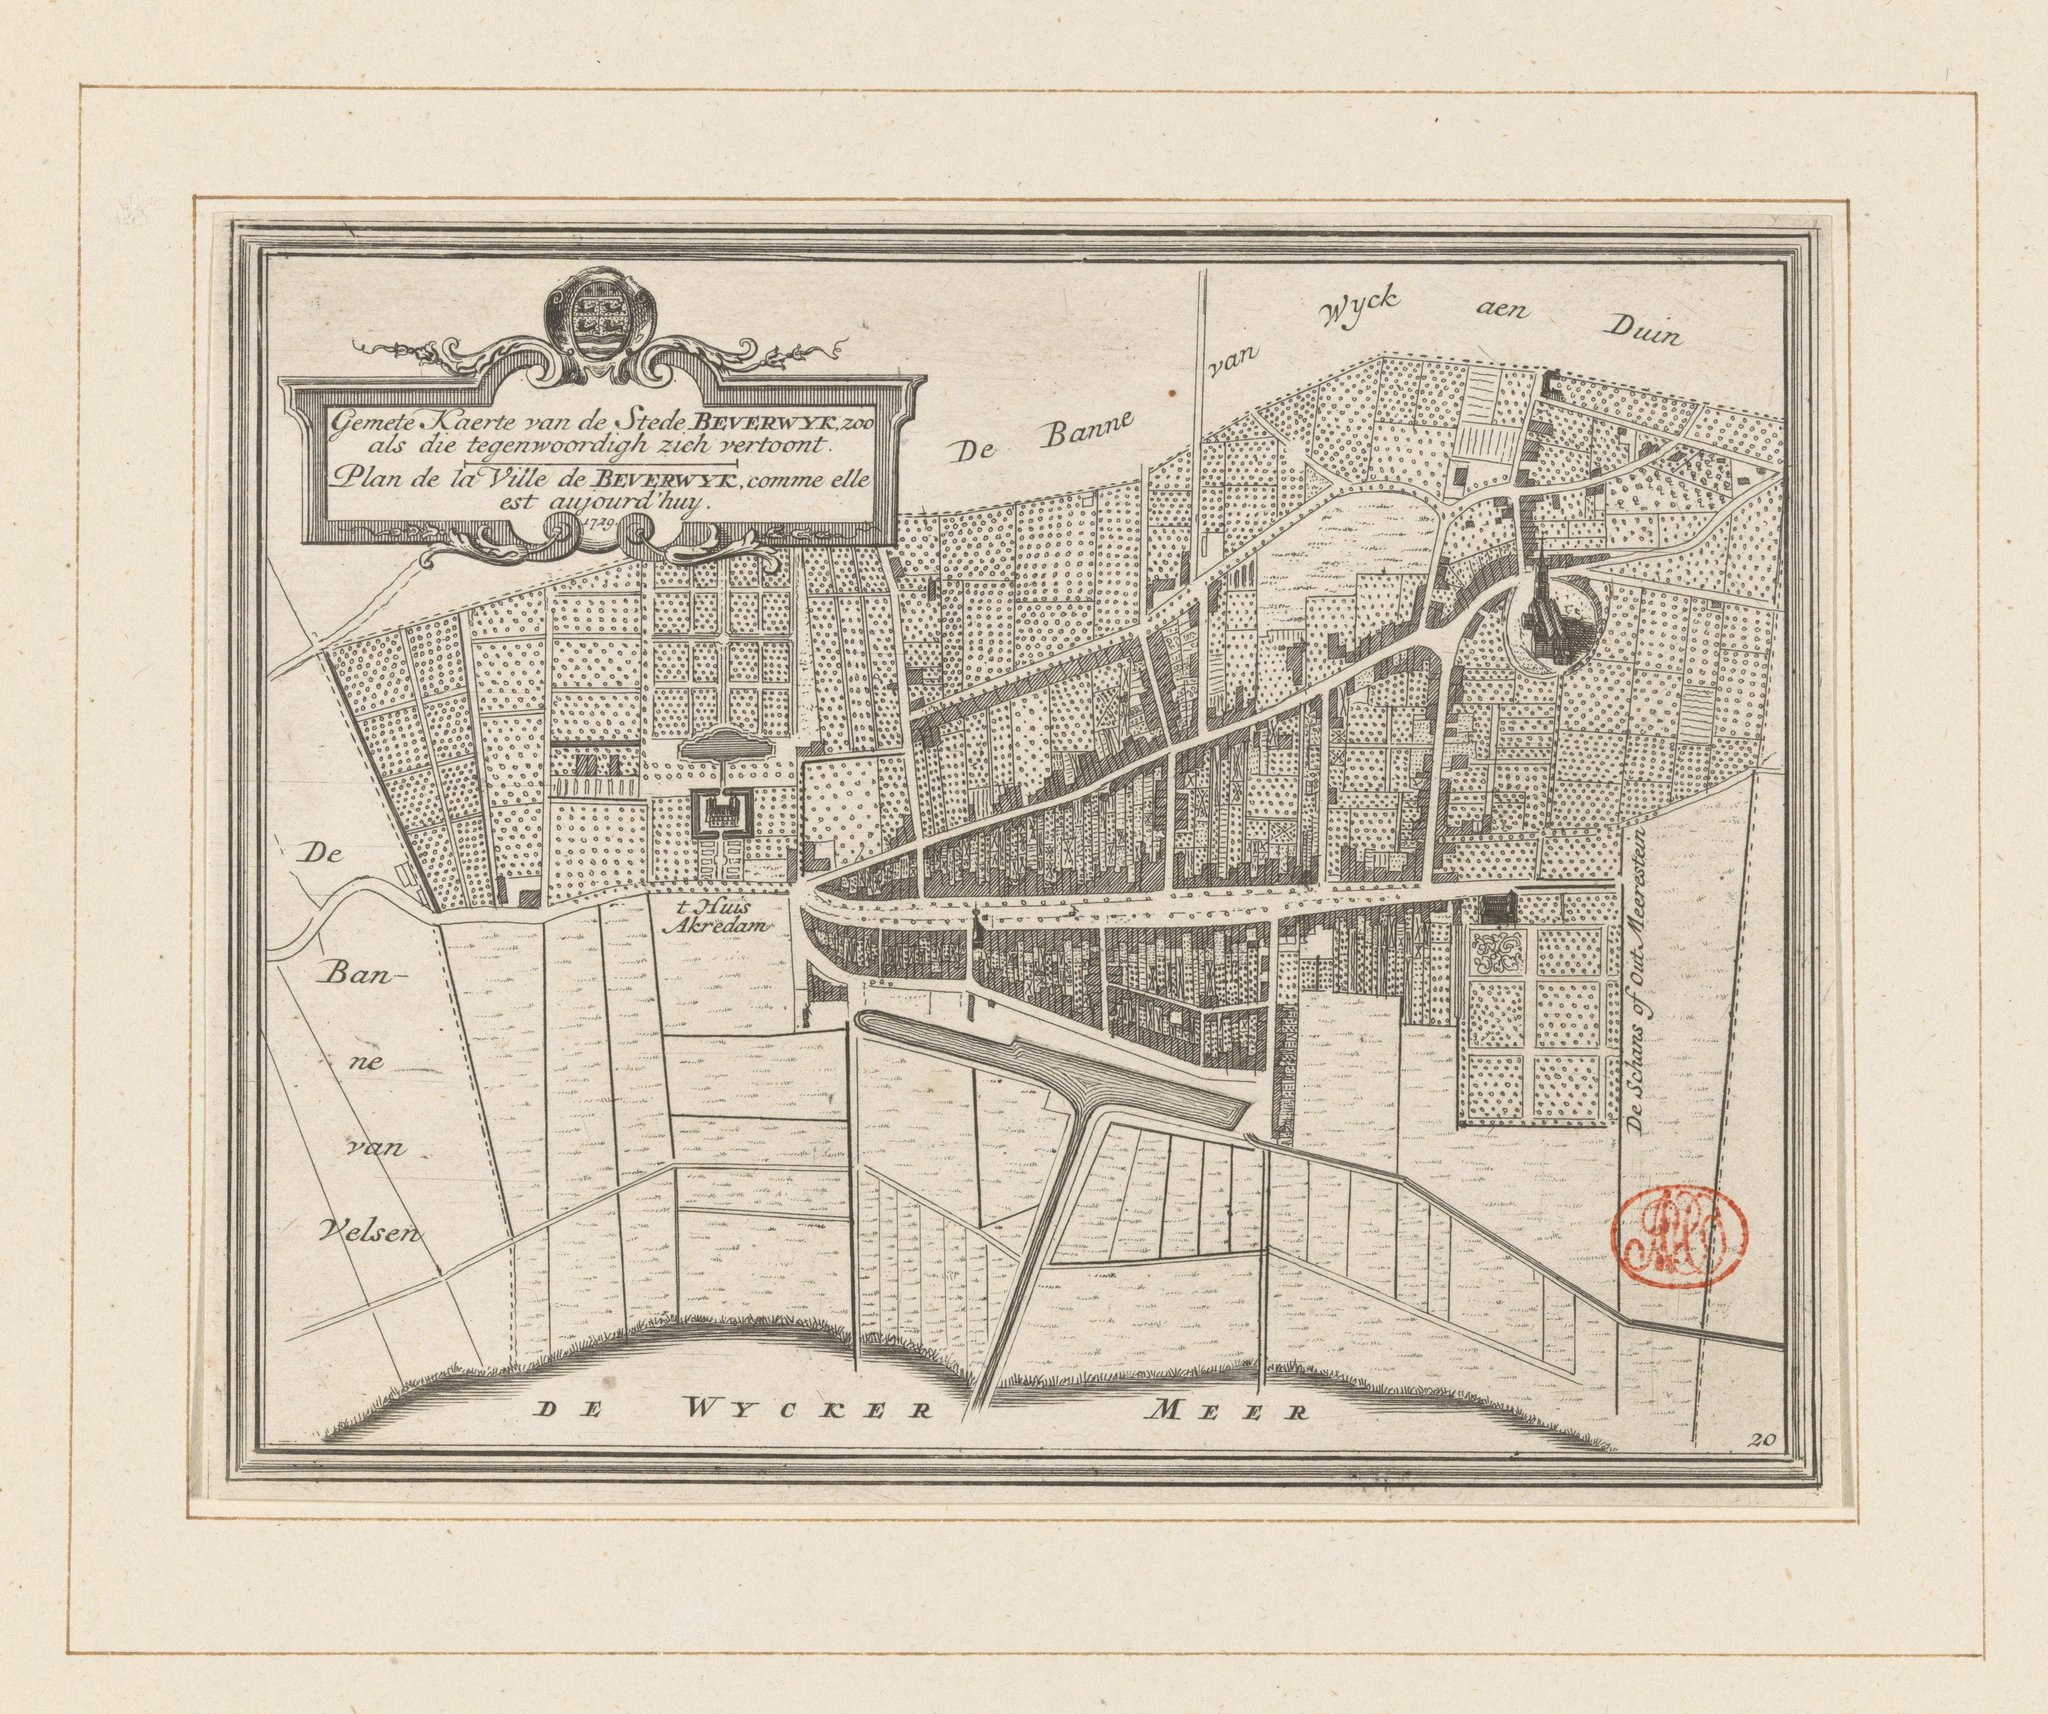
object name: print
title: Plattegrond van Beverwijk, 1729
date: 1729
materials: paper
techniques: engraving, etching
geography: amsterdam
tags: coat of arms (as symbol of the state, etc.) (+ city; municipal), maps of cities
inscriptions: collector's mark: Lugt 195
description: Prent ook gebruikt in: Brouërius van Nidek, Matthaeus. Het zegenpralent Kennemerlant, vertoont in (…). 2 delen. Amsterdam: Andries en Hendrik de Leth, 1729-1732, deel 1 (1729).